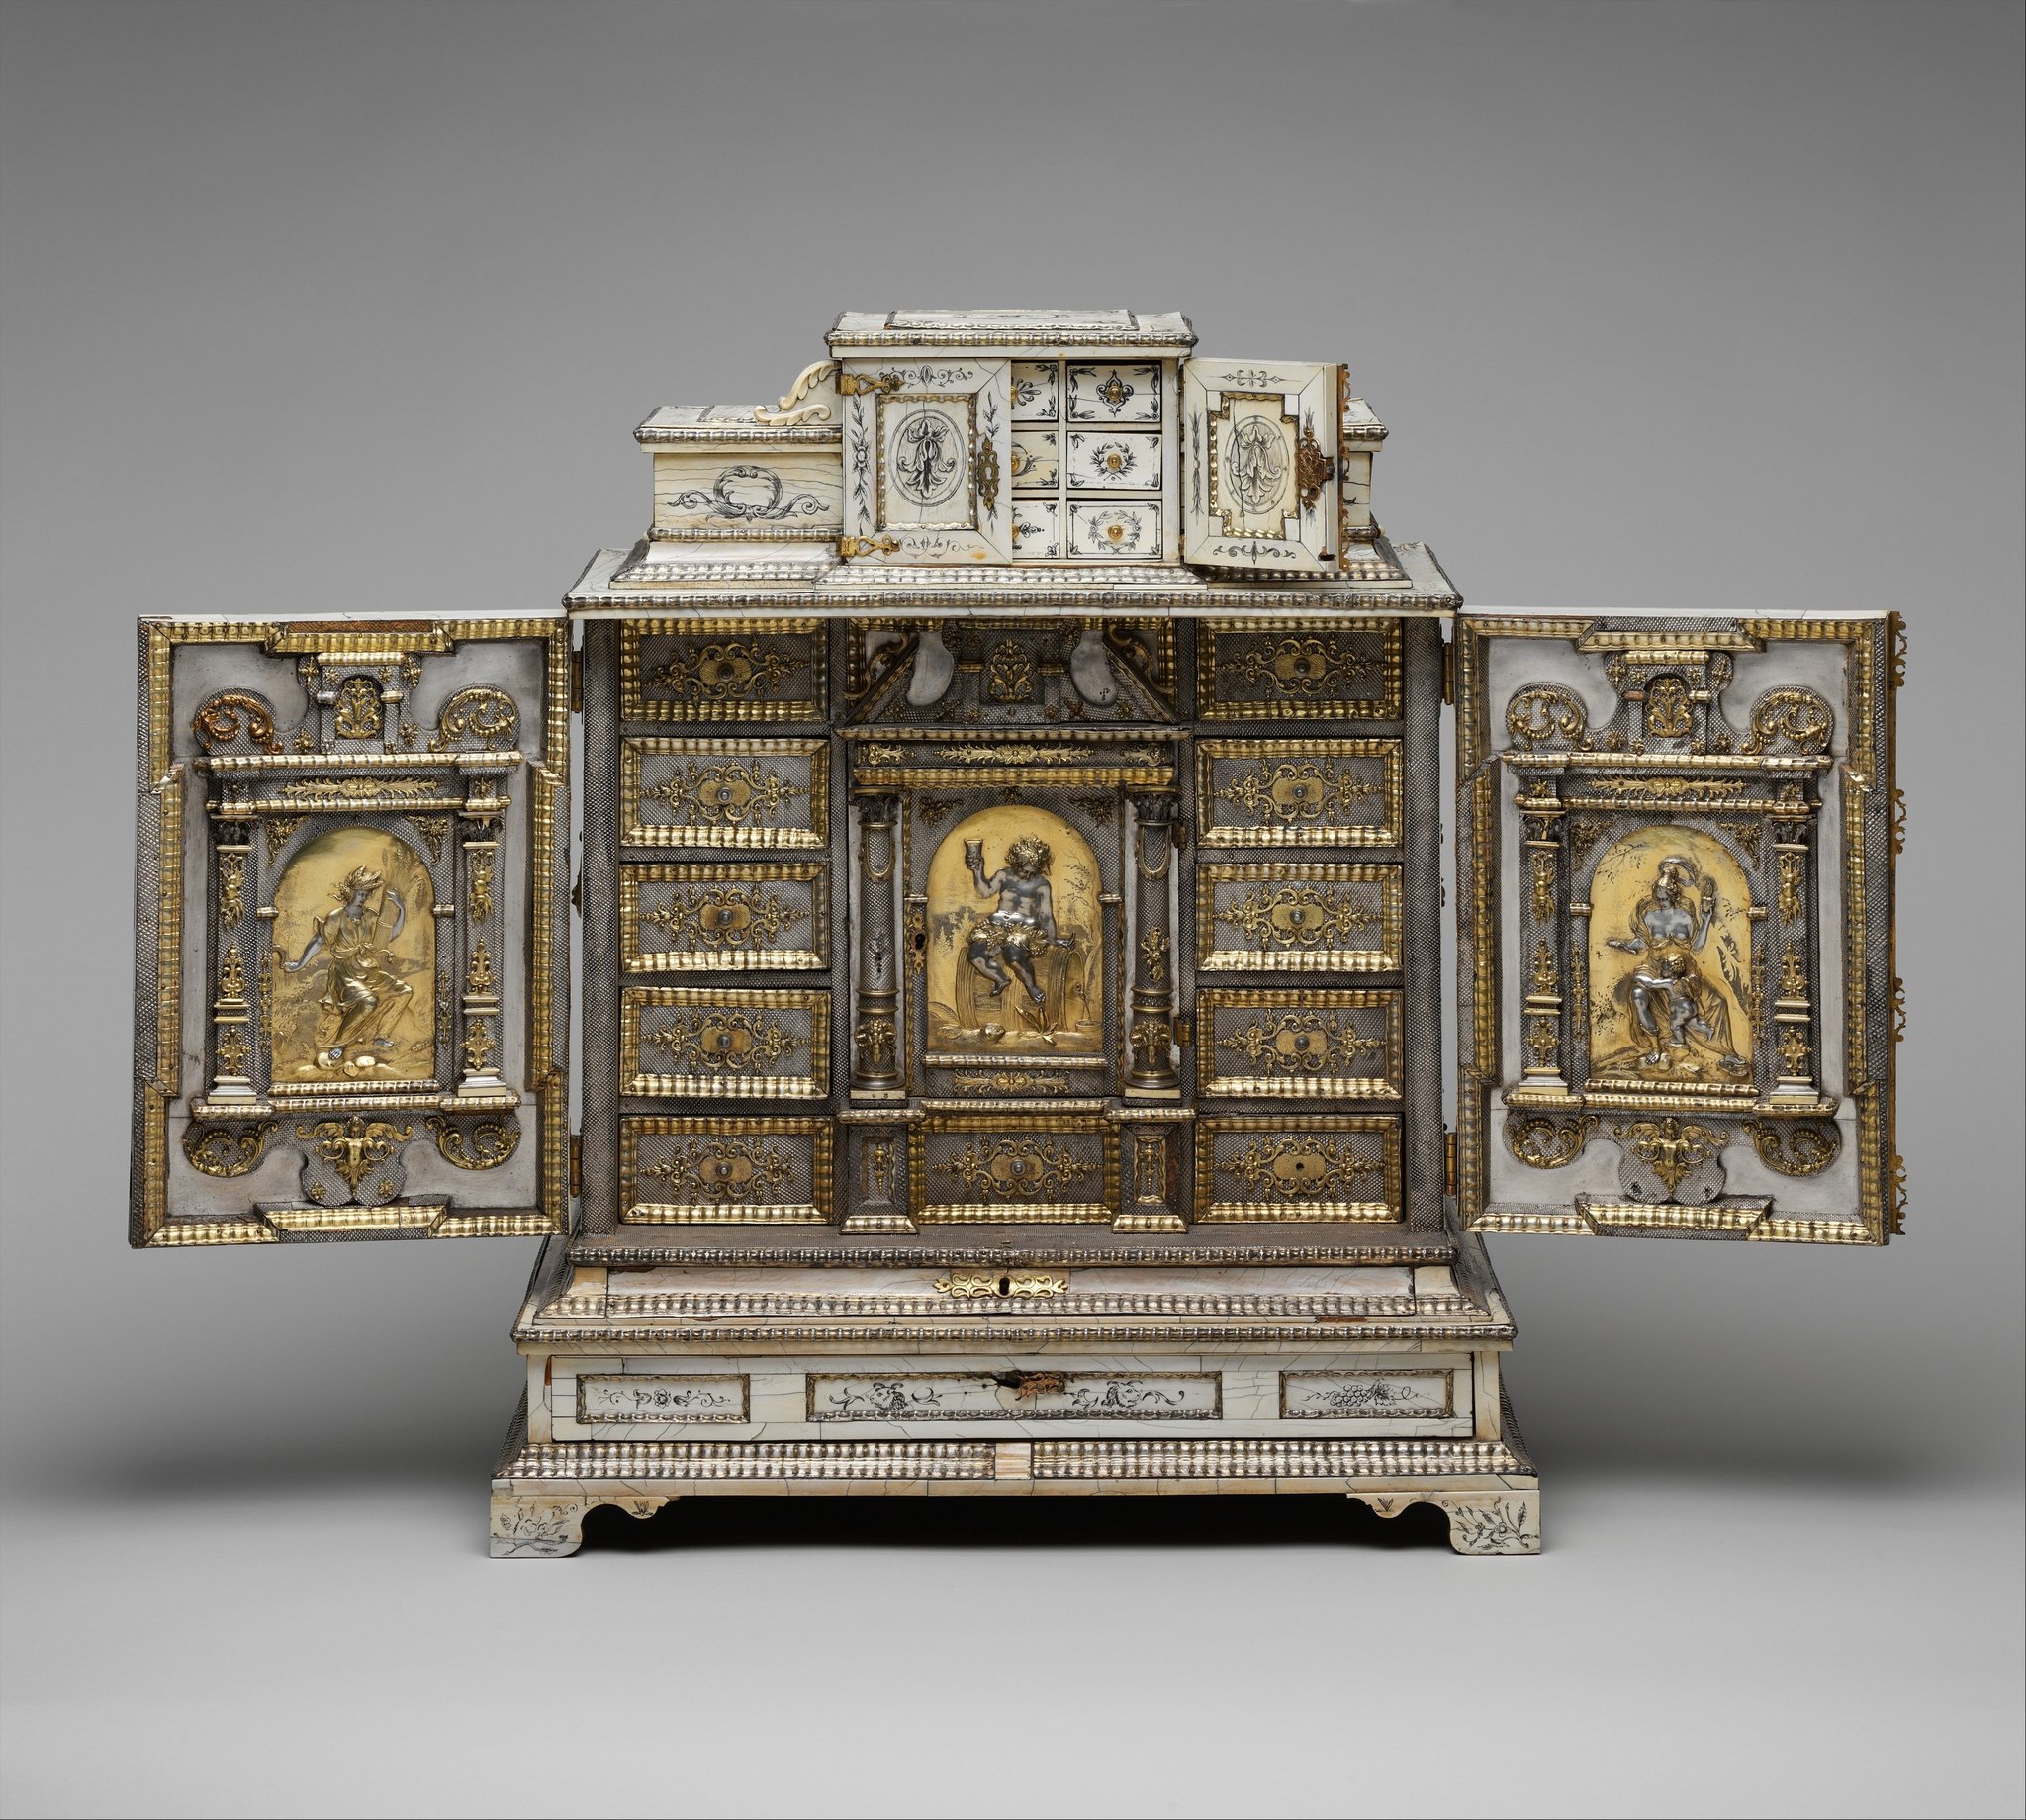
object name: cabinet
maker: melchior baumgartner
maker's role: maker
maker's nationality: german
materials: gemstone, wood, ivory, metal, silk, silver, silver gilt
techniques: gilding, veneering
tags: cupid,bacchus,ceres,venus